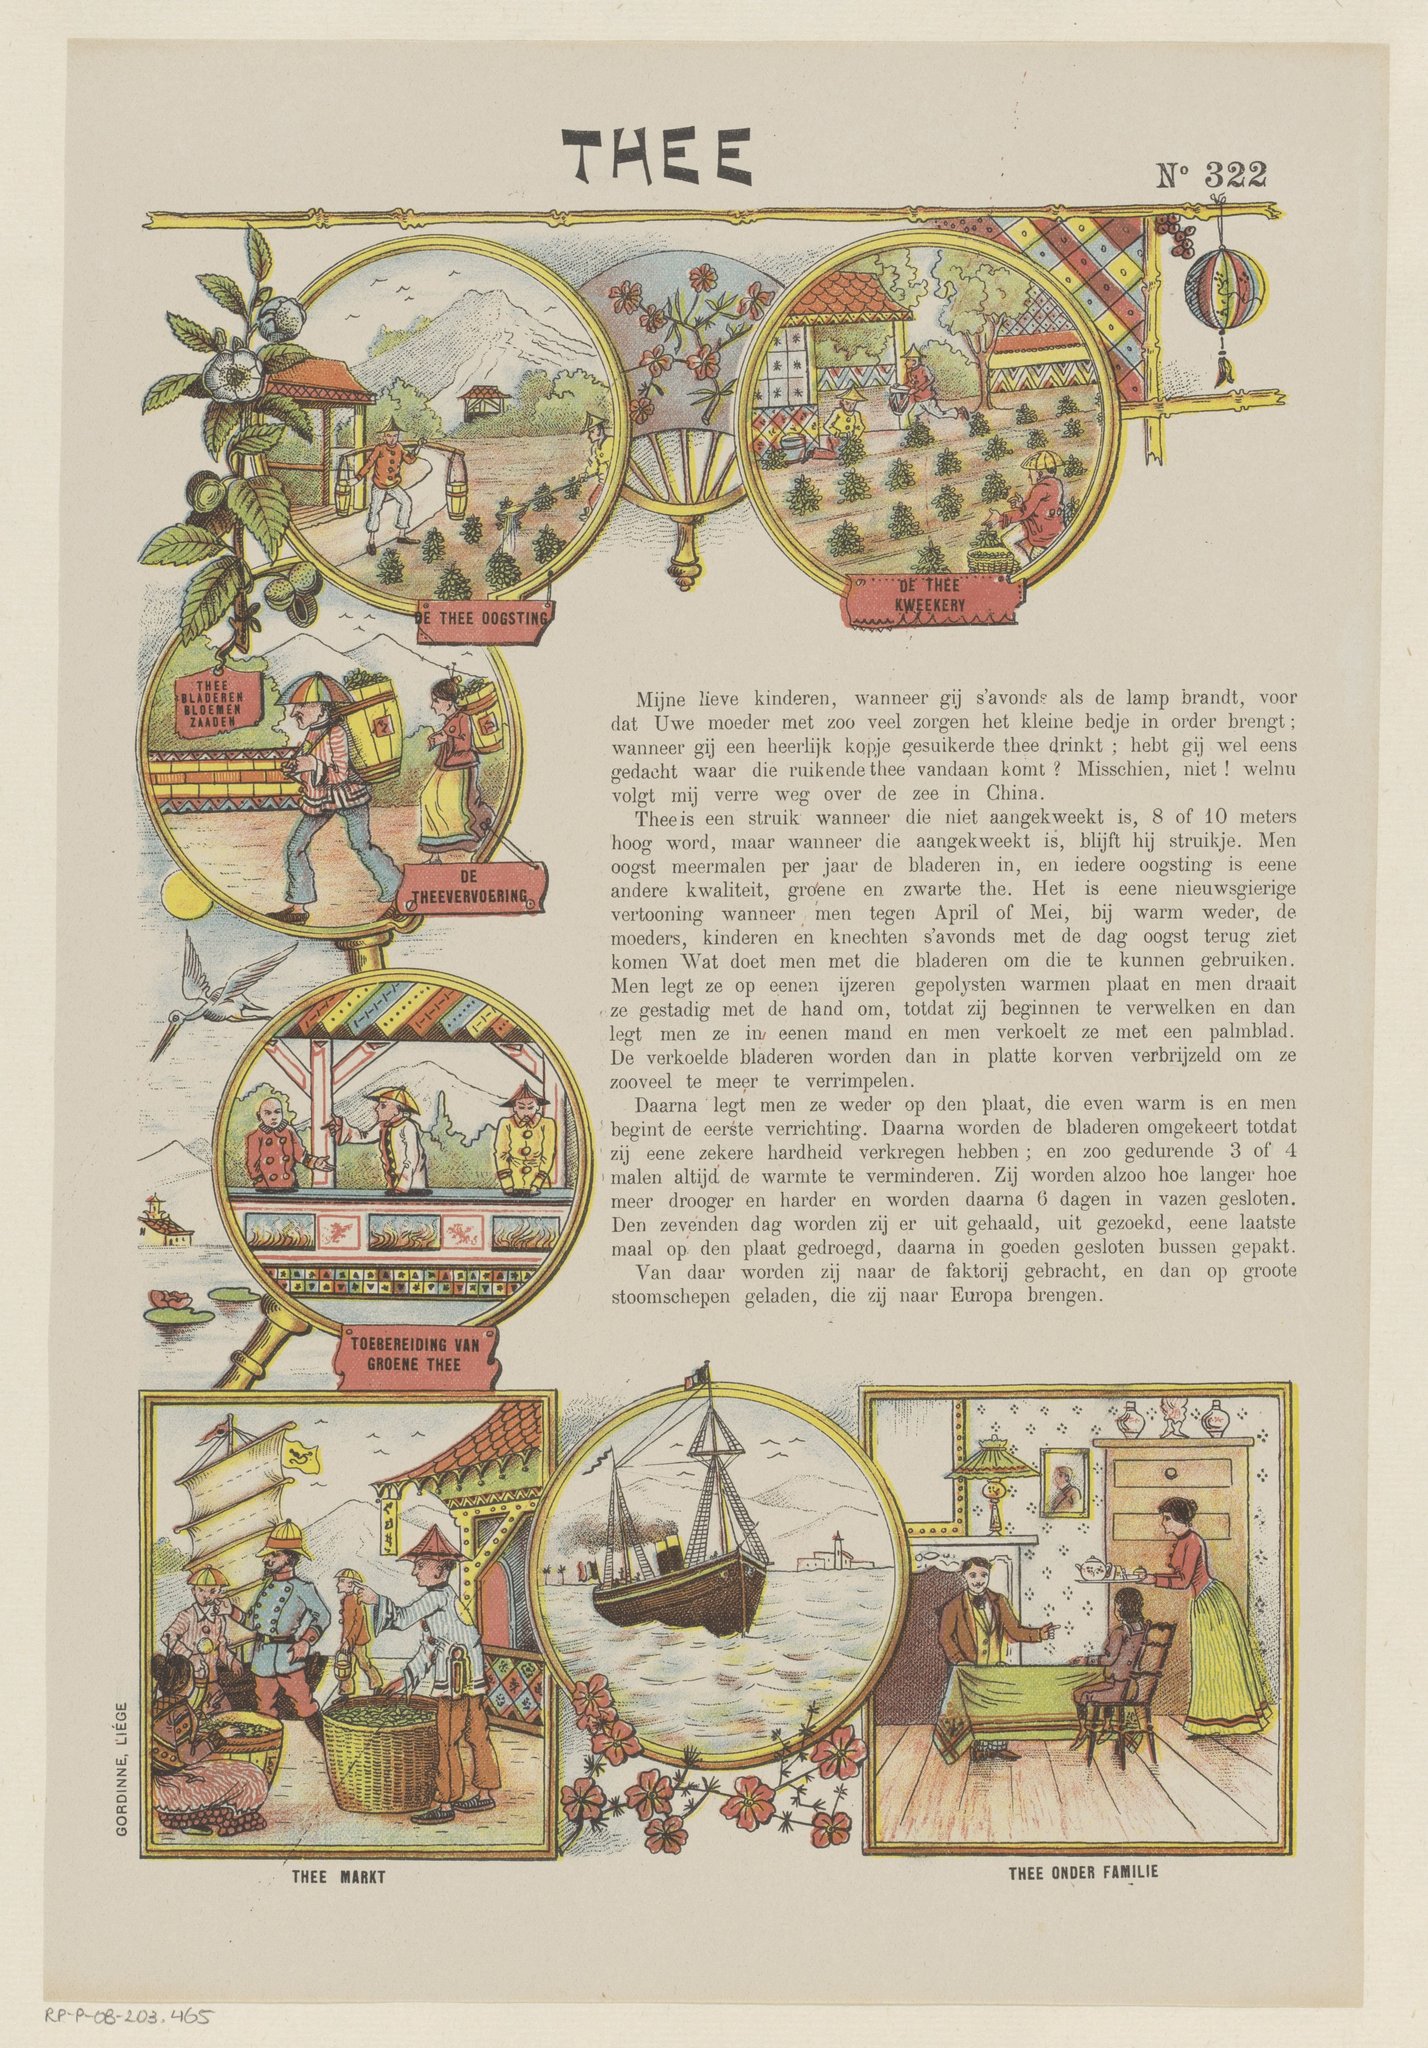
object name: print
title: Thee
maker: Anonymous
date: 1894-1959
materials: paper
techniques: lithograph, letterpress printing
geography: liège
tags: tea (leaves), china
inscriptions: collector's mark: Lugt 2760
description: Blad met verschillende voorstellingen over de herkomst, de productie en het gebruik van thee in China. Midden rechts een tekstvak. Genummerd rechtsboven: No 322.